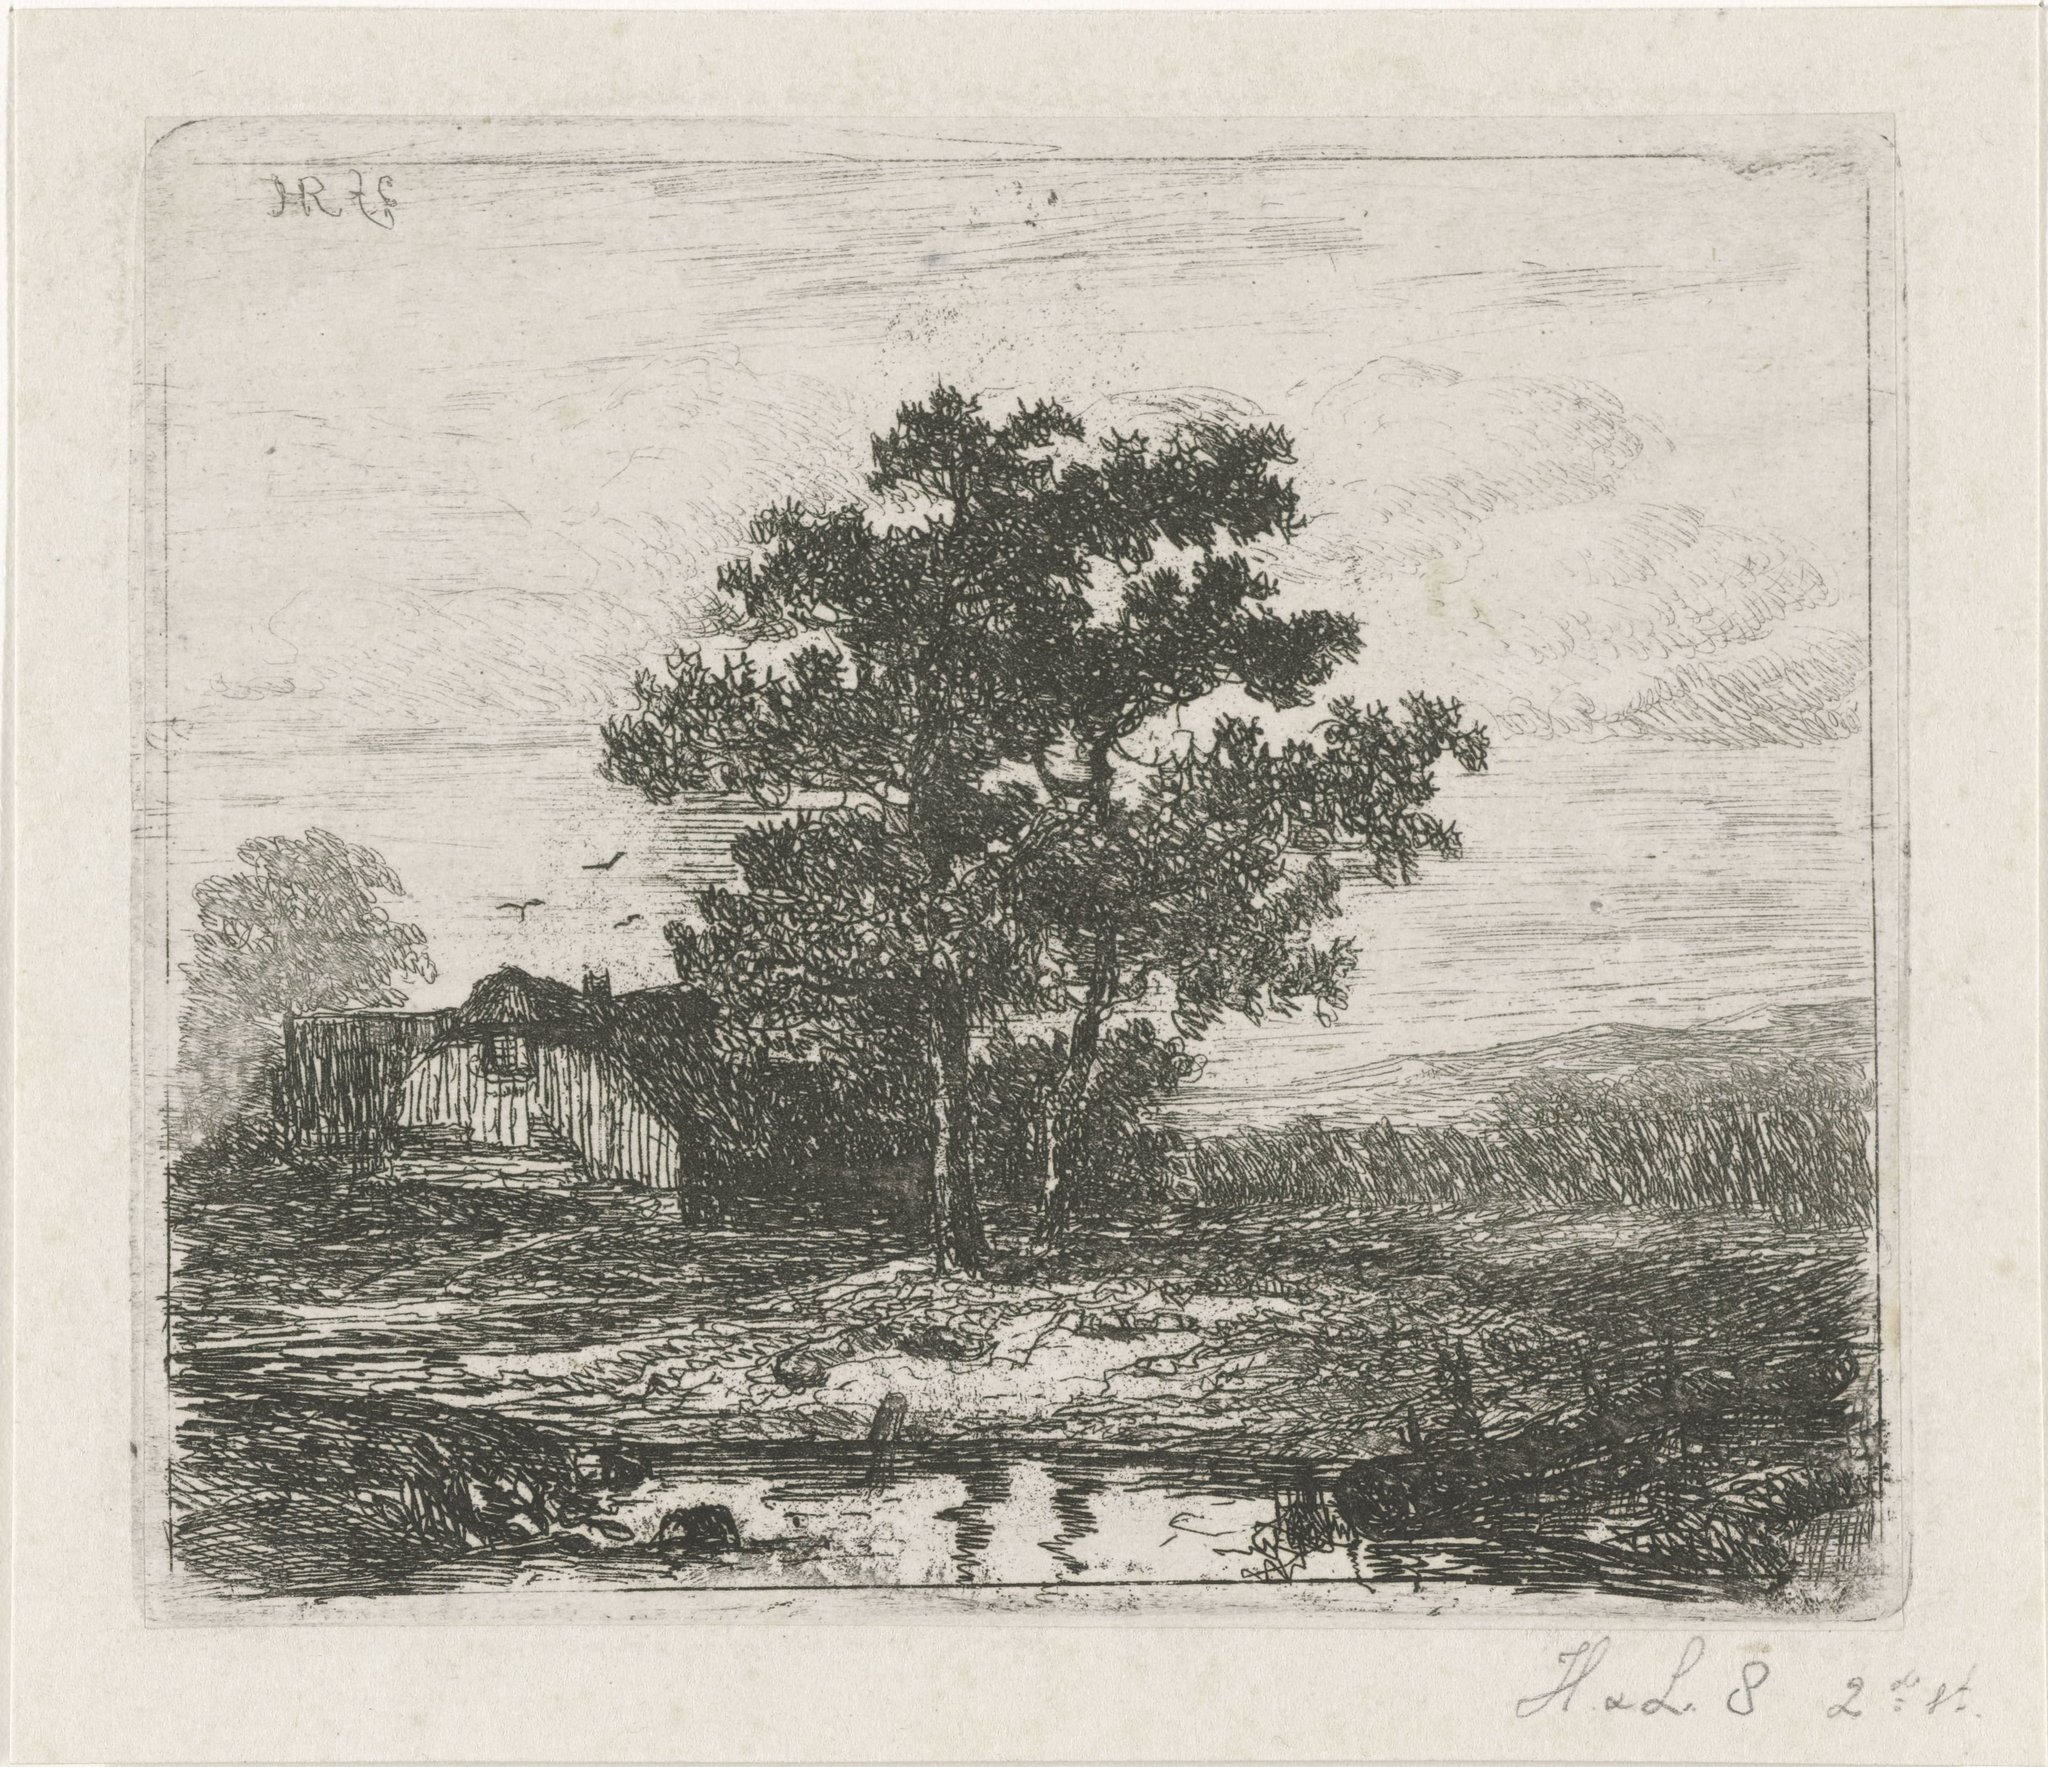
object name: print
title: Twee eiken bij een houten huis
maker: hermanus jan hendrik van rijkelijkhuysen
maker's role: painter, print maker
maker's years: 1813-1883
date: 1823-1883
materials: paper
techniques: etching, intaglio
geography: utrecht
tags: trees: oak, pool, puddle, farm or solitary house in landscape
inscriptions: collector's mark: Lugt 2228